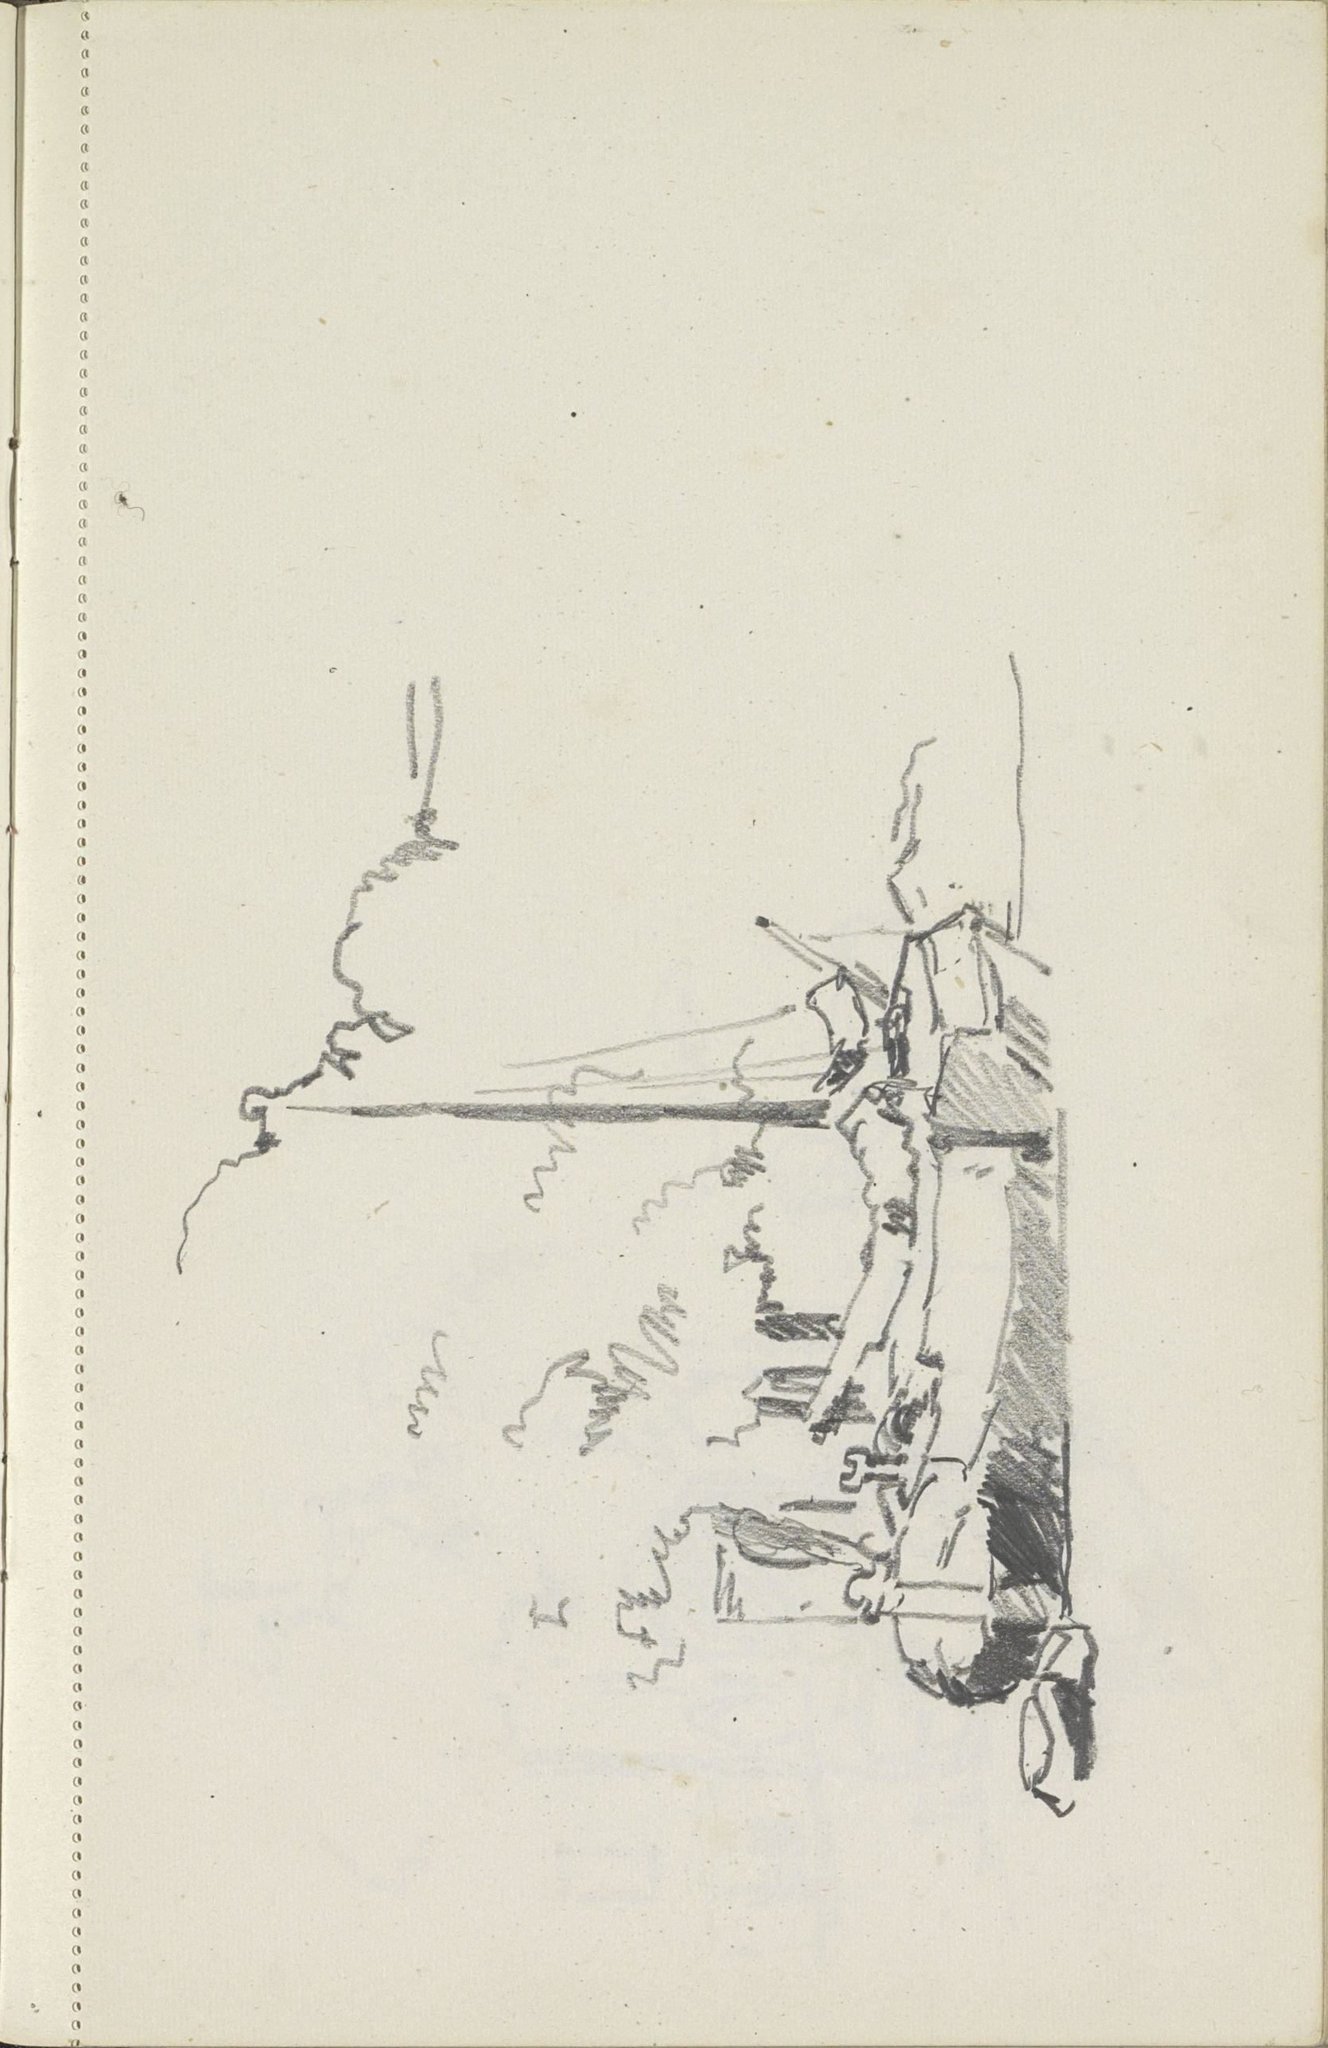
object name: sketchbook leaf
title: Aangemeerde zeilboot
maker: cornelis vreedenburgh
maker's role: draughtsman, print maker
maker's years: 1880-1946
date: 1890-1946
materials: paper, pencil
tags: sailing-ship, sailing-boat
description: Blad 13 recto uit een schetsboek met 50 bladen.